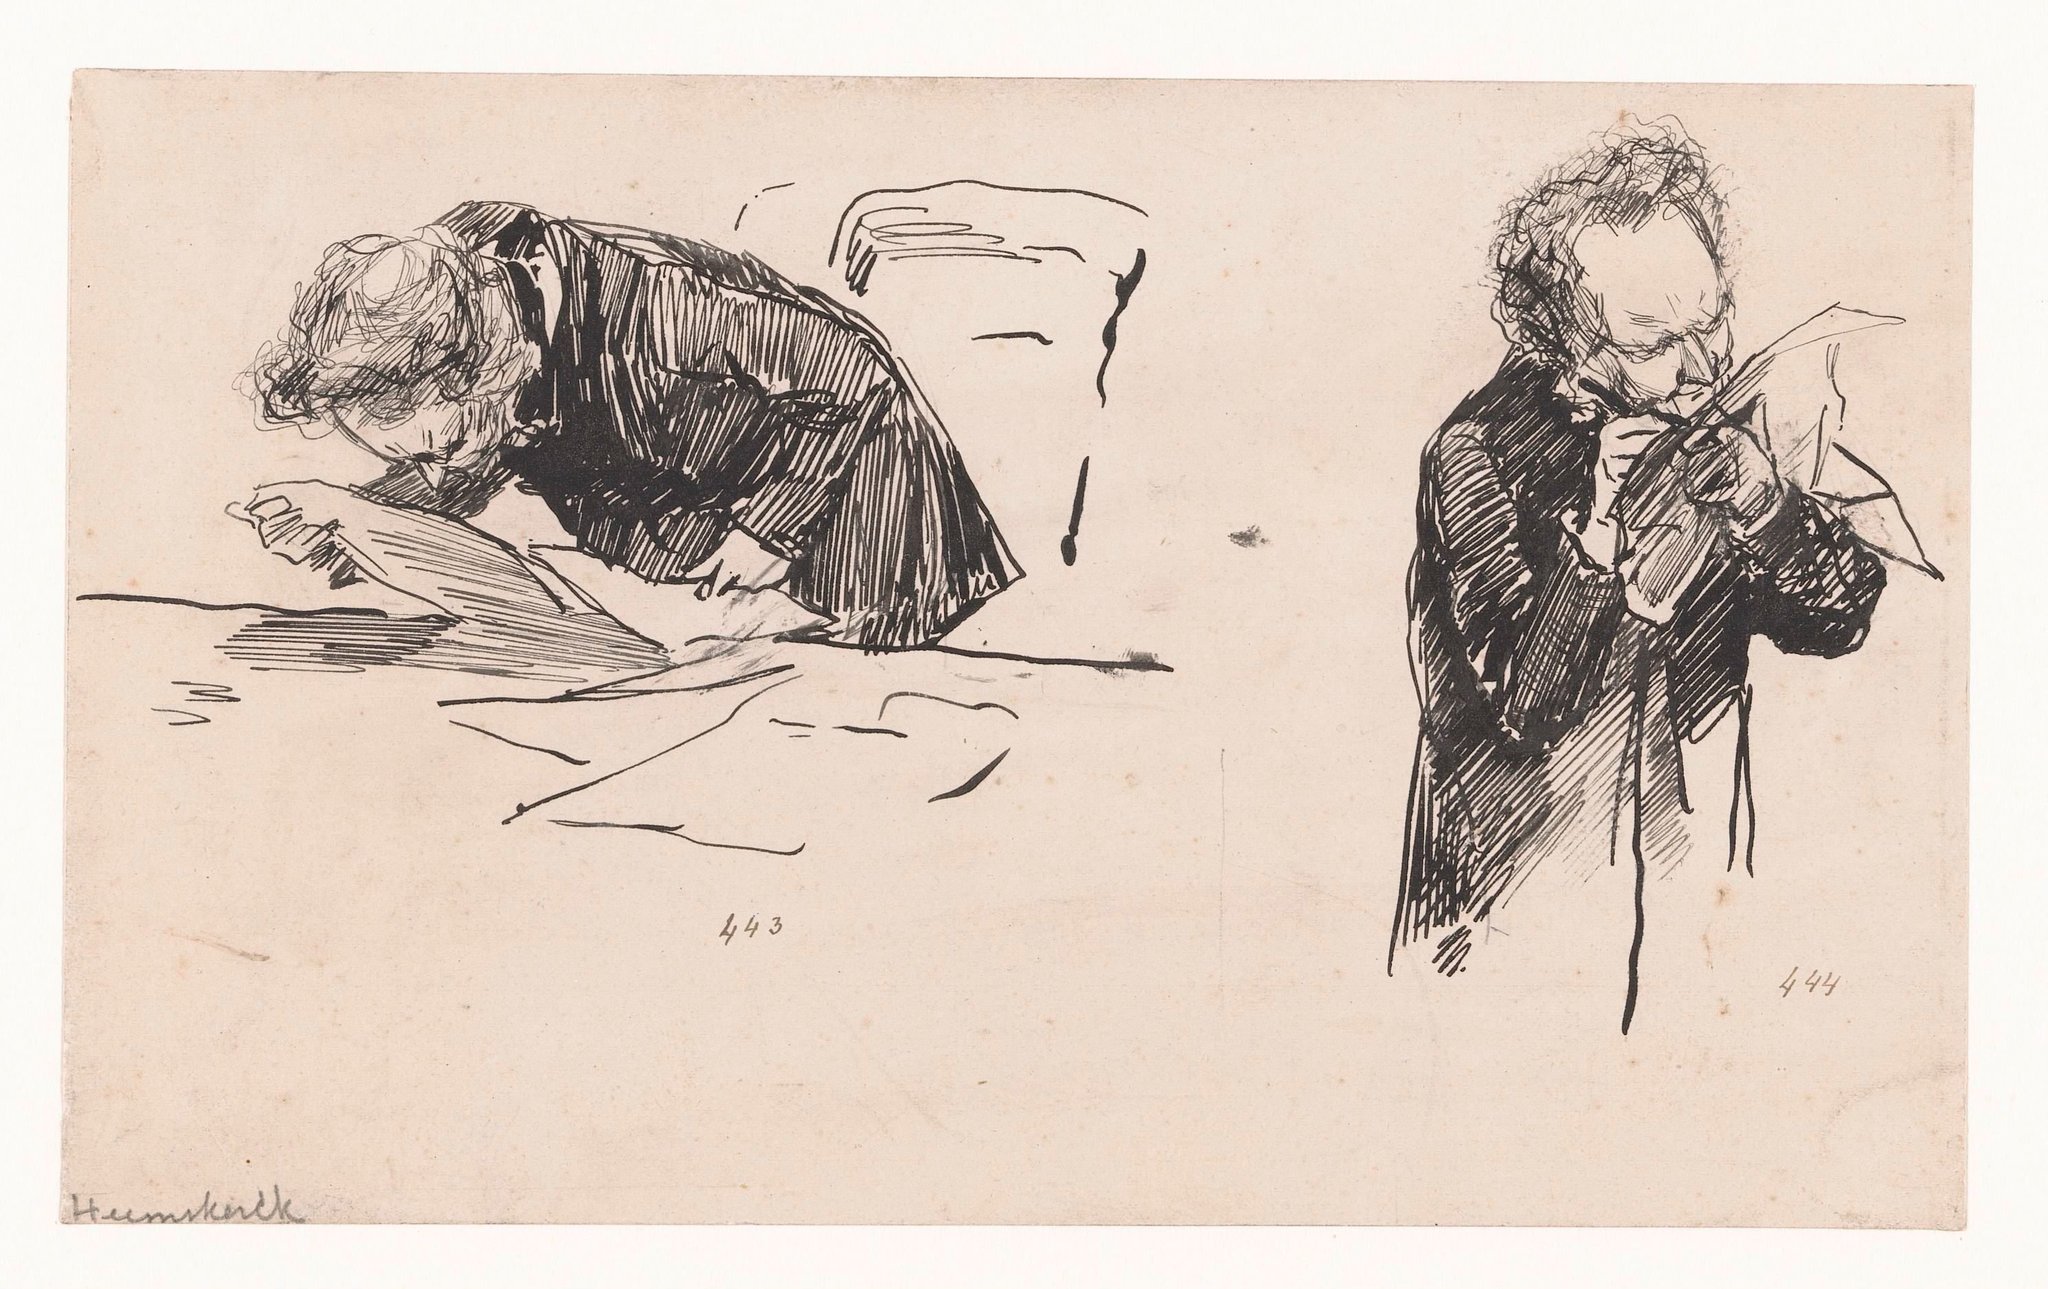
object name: drawing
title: Twee schetsen van minister Heemskerck in de Tweede Kamer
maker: pieter de josselin de jong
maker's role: draughtsman, painter, print maker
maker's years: 1861-1906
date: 1887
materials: ink, paper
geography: the hague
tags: amsterdam, the hague, politician, minister ~ government, historical persons, netherlands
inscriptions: inscription: ‘443 / 444 / Heemskerck’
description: Twee schetsen van de Minister van Staat en Binnenlandse zaken Mr. J. Heemskerck Azn., links voorovergebogen over een document op een tafel, rechts met papier en pen onder zijn neus. Onderdeel van een groep schetsen van de bespreking in de Tweede Kamer van de grondwetsherziening van 1887 gepubliceerd in het weekblad Eigen Haard (1887).